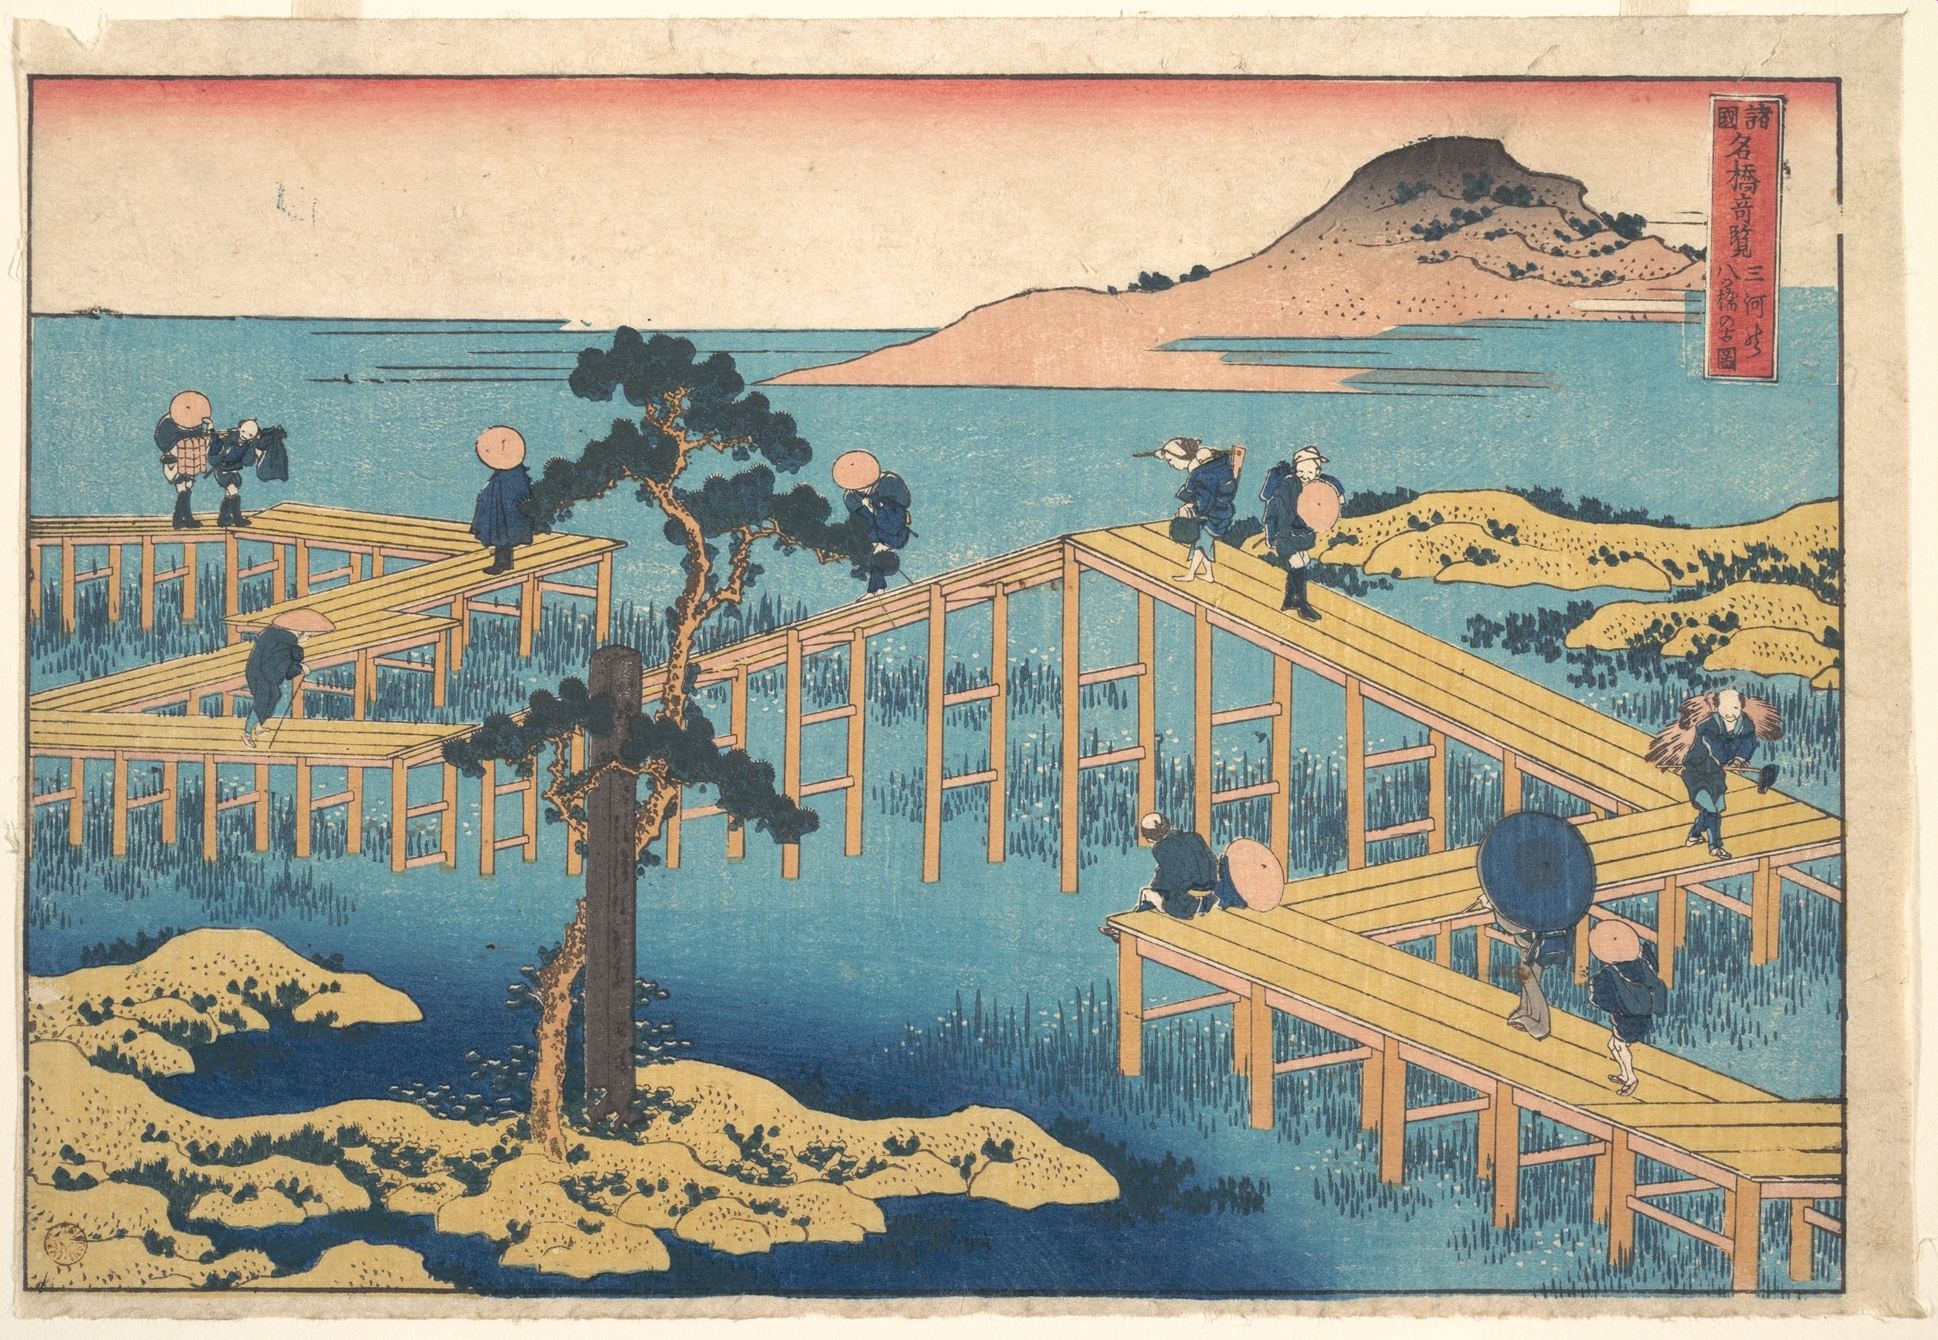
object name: woodblock print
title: Ancient View of Yatsuhashi in Mikawa Province (Mikawa no Yatsuhashi no kozu), from the series Remarkable Views of Bridges in Various Provinces (Shokoku meikyō kiran)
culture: japanese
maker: katsushika hokusai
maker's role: artist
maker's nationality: japanese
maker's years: 1760-1849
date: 1834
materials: ink, paper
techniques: woodblock print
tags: human figures,bridges,mountains,trees